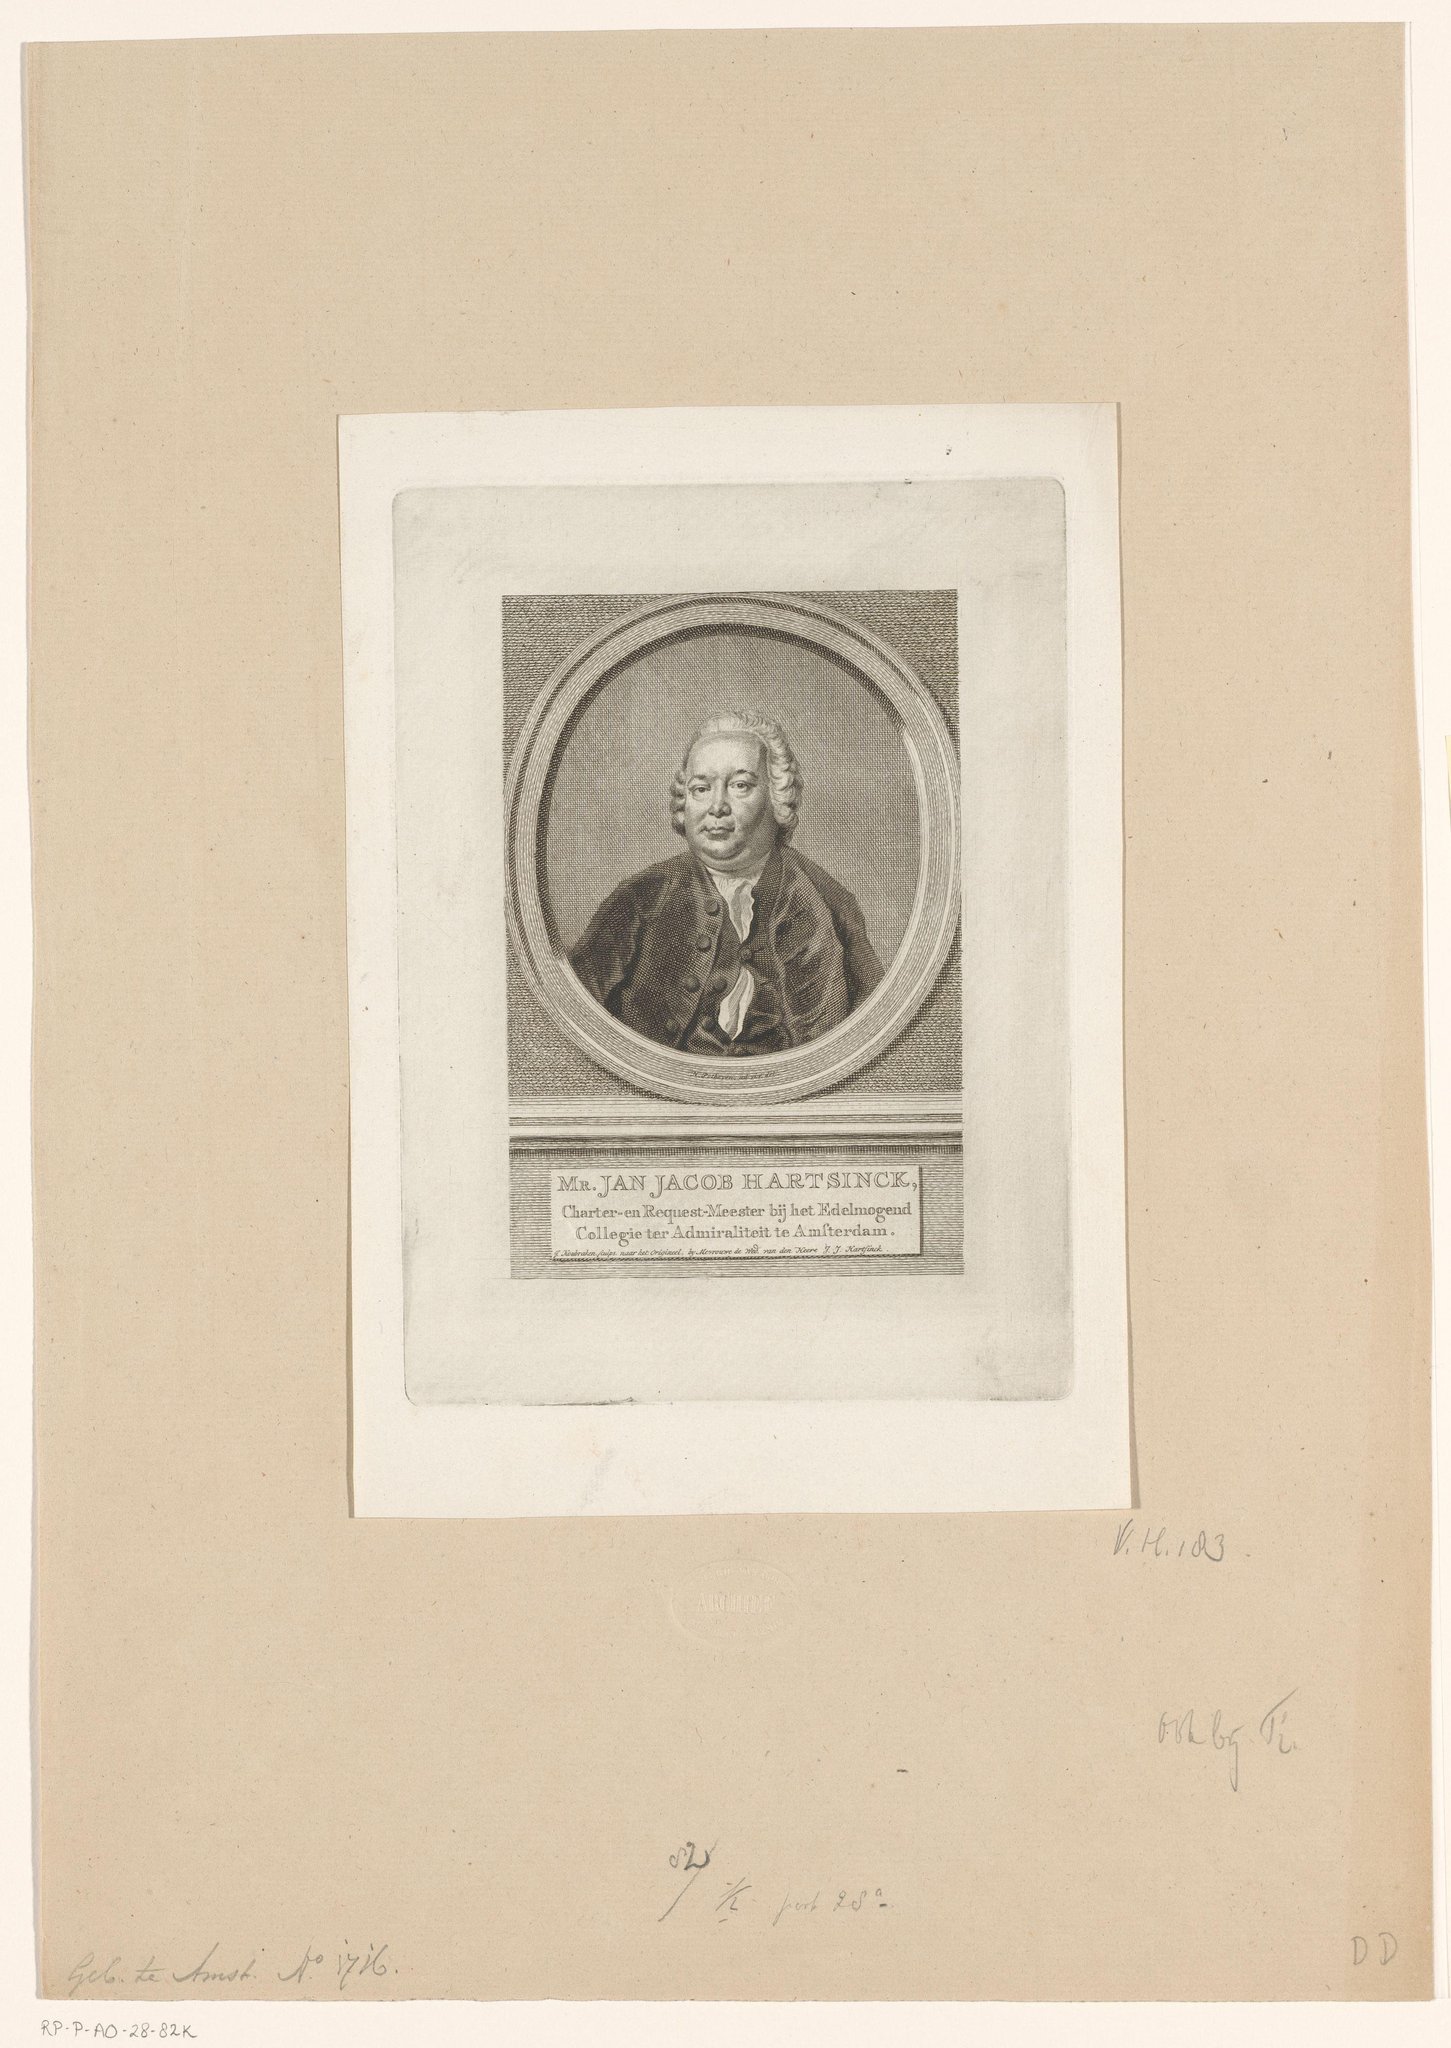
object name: print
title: Portret van Jan Jacob Hartsinck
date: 1779-1780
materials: paper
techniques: engraving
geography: amsterdam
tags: amsterdam, historical persons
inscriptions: check stamp: ‘Archief Ministerie van Oorlog Afdeeling Genie’, collector's mark: Lugt 2228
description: Portret van Jan Jacob Hartsinck, charter- en rekestmeester van de Admiraliteit van Amsterdam, in een ovaal. Het portret rust op een plint met daarop zijn naam en gegevens in drie regels in het Nederlands.